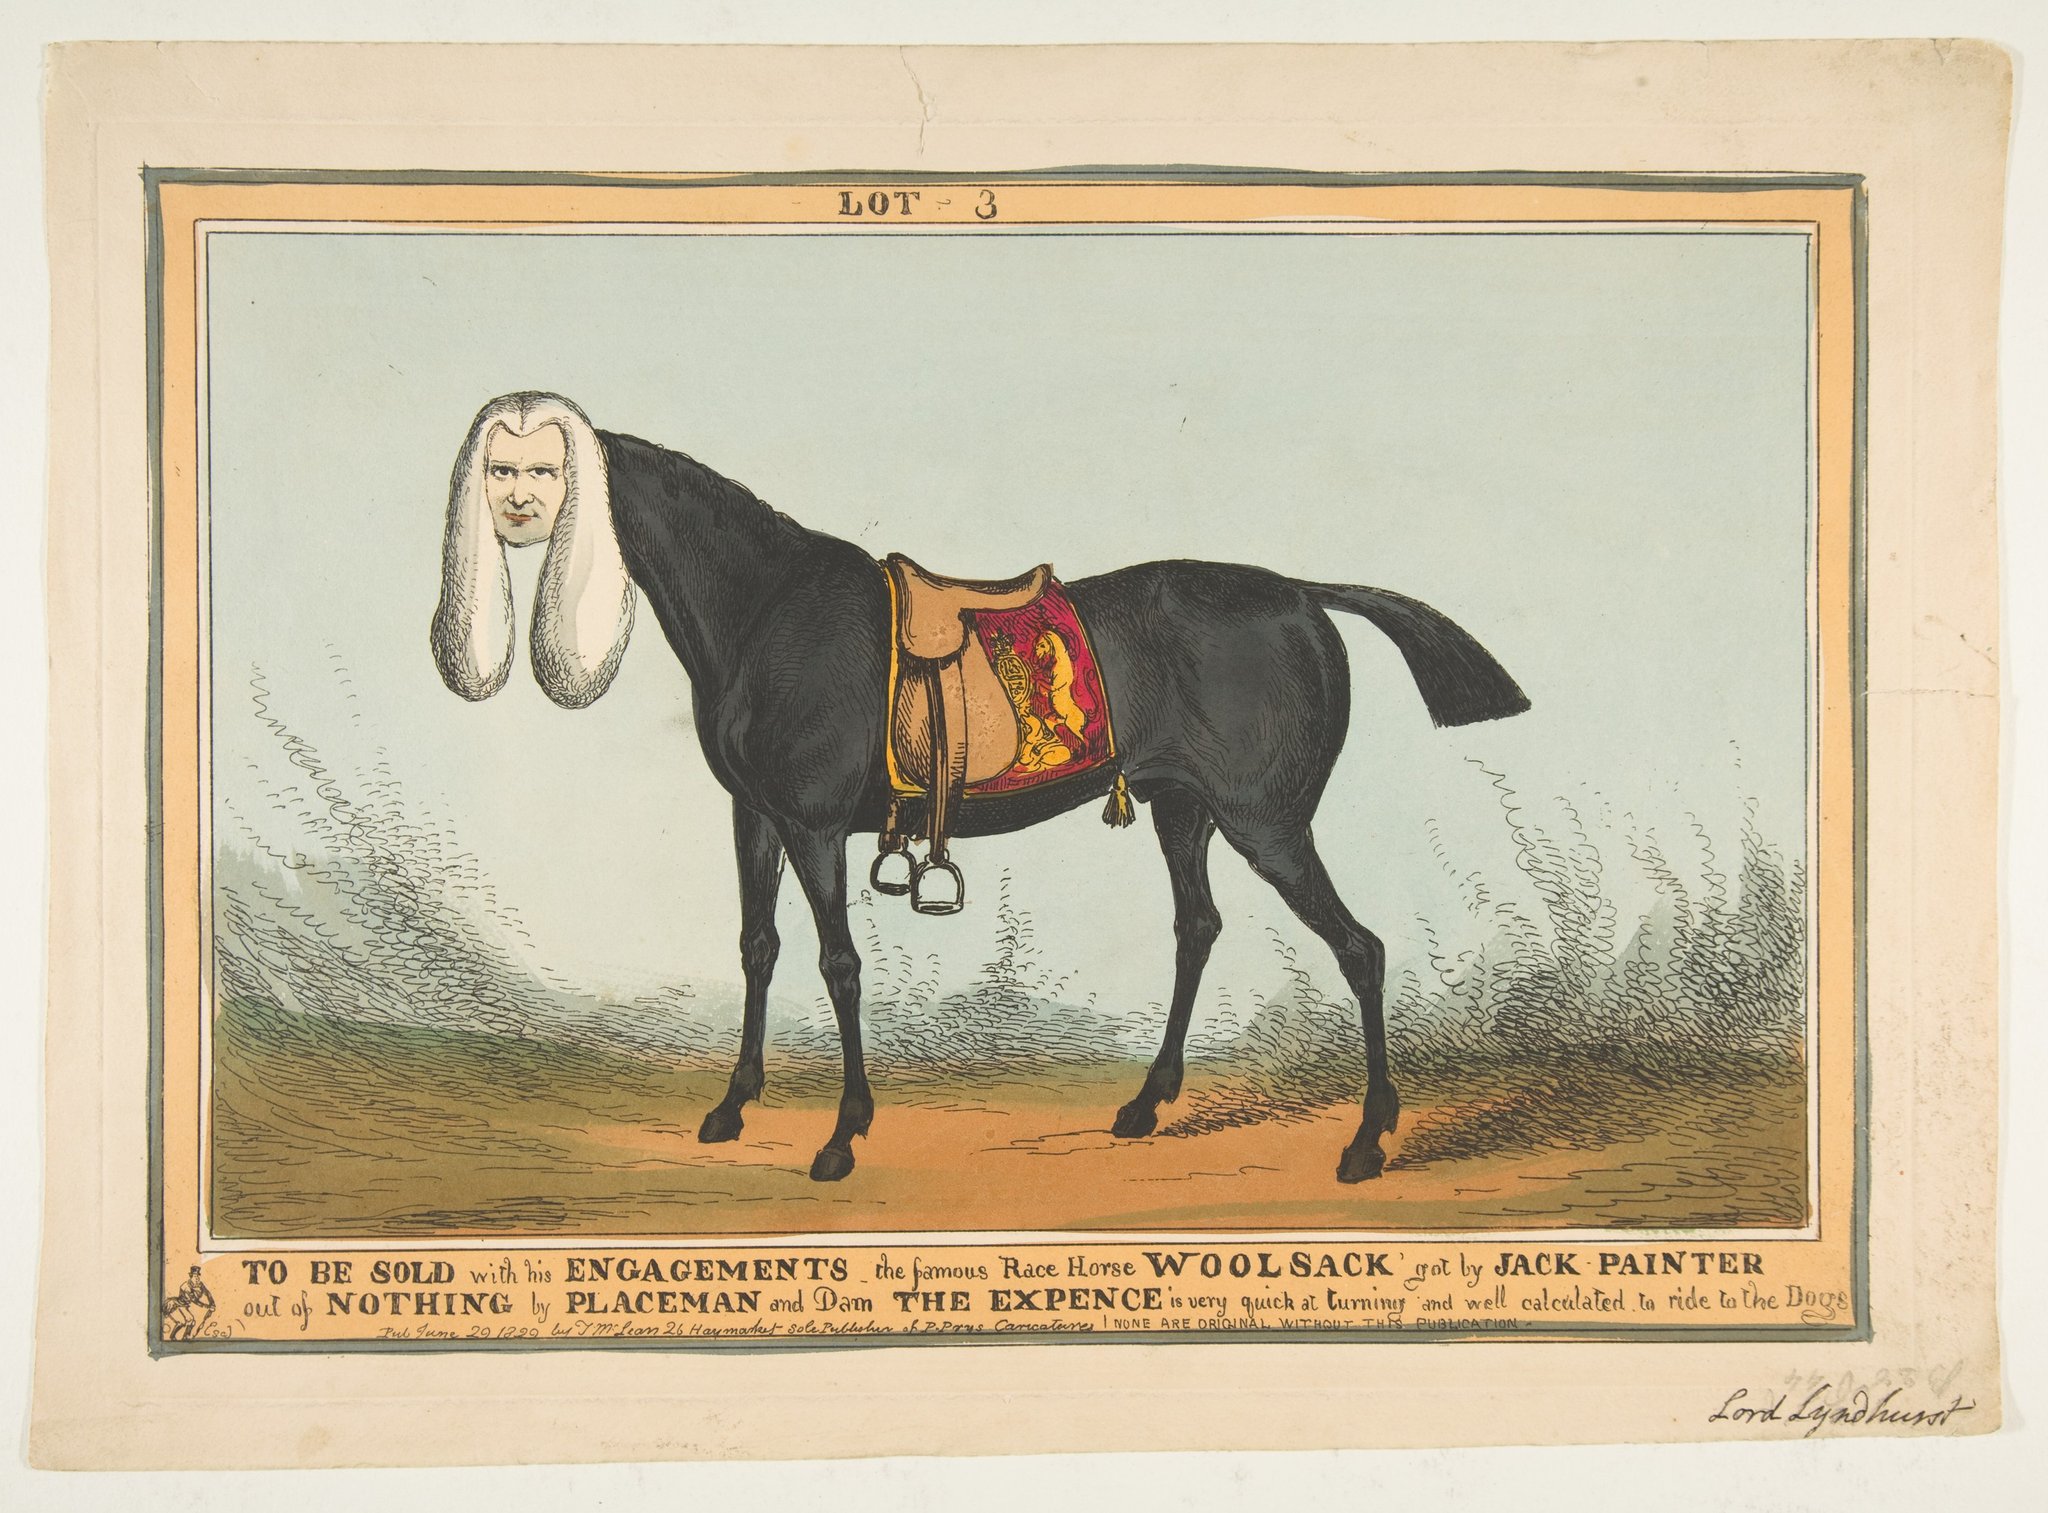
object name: print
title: To Be Sold With All His Engagements–The Famous Race Horse Woolsack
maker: william heath ('paul pry')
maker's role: artist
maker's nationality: british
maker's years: 1794-1840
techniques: etching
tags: satire,horses,politics